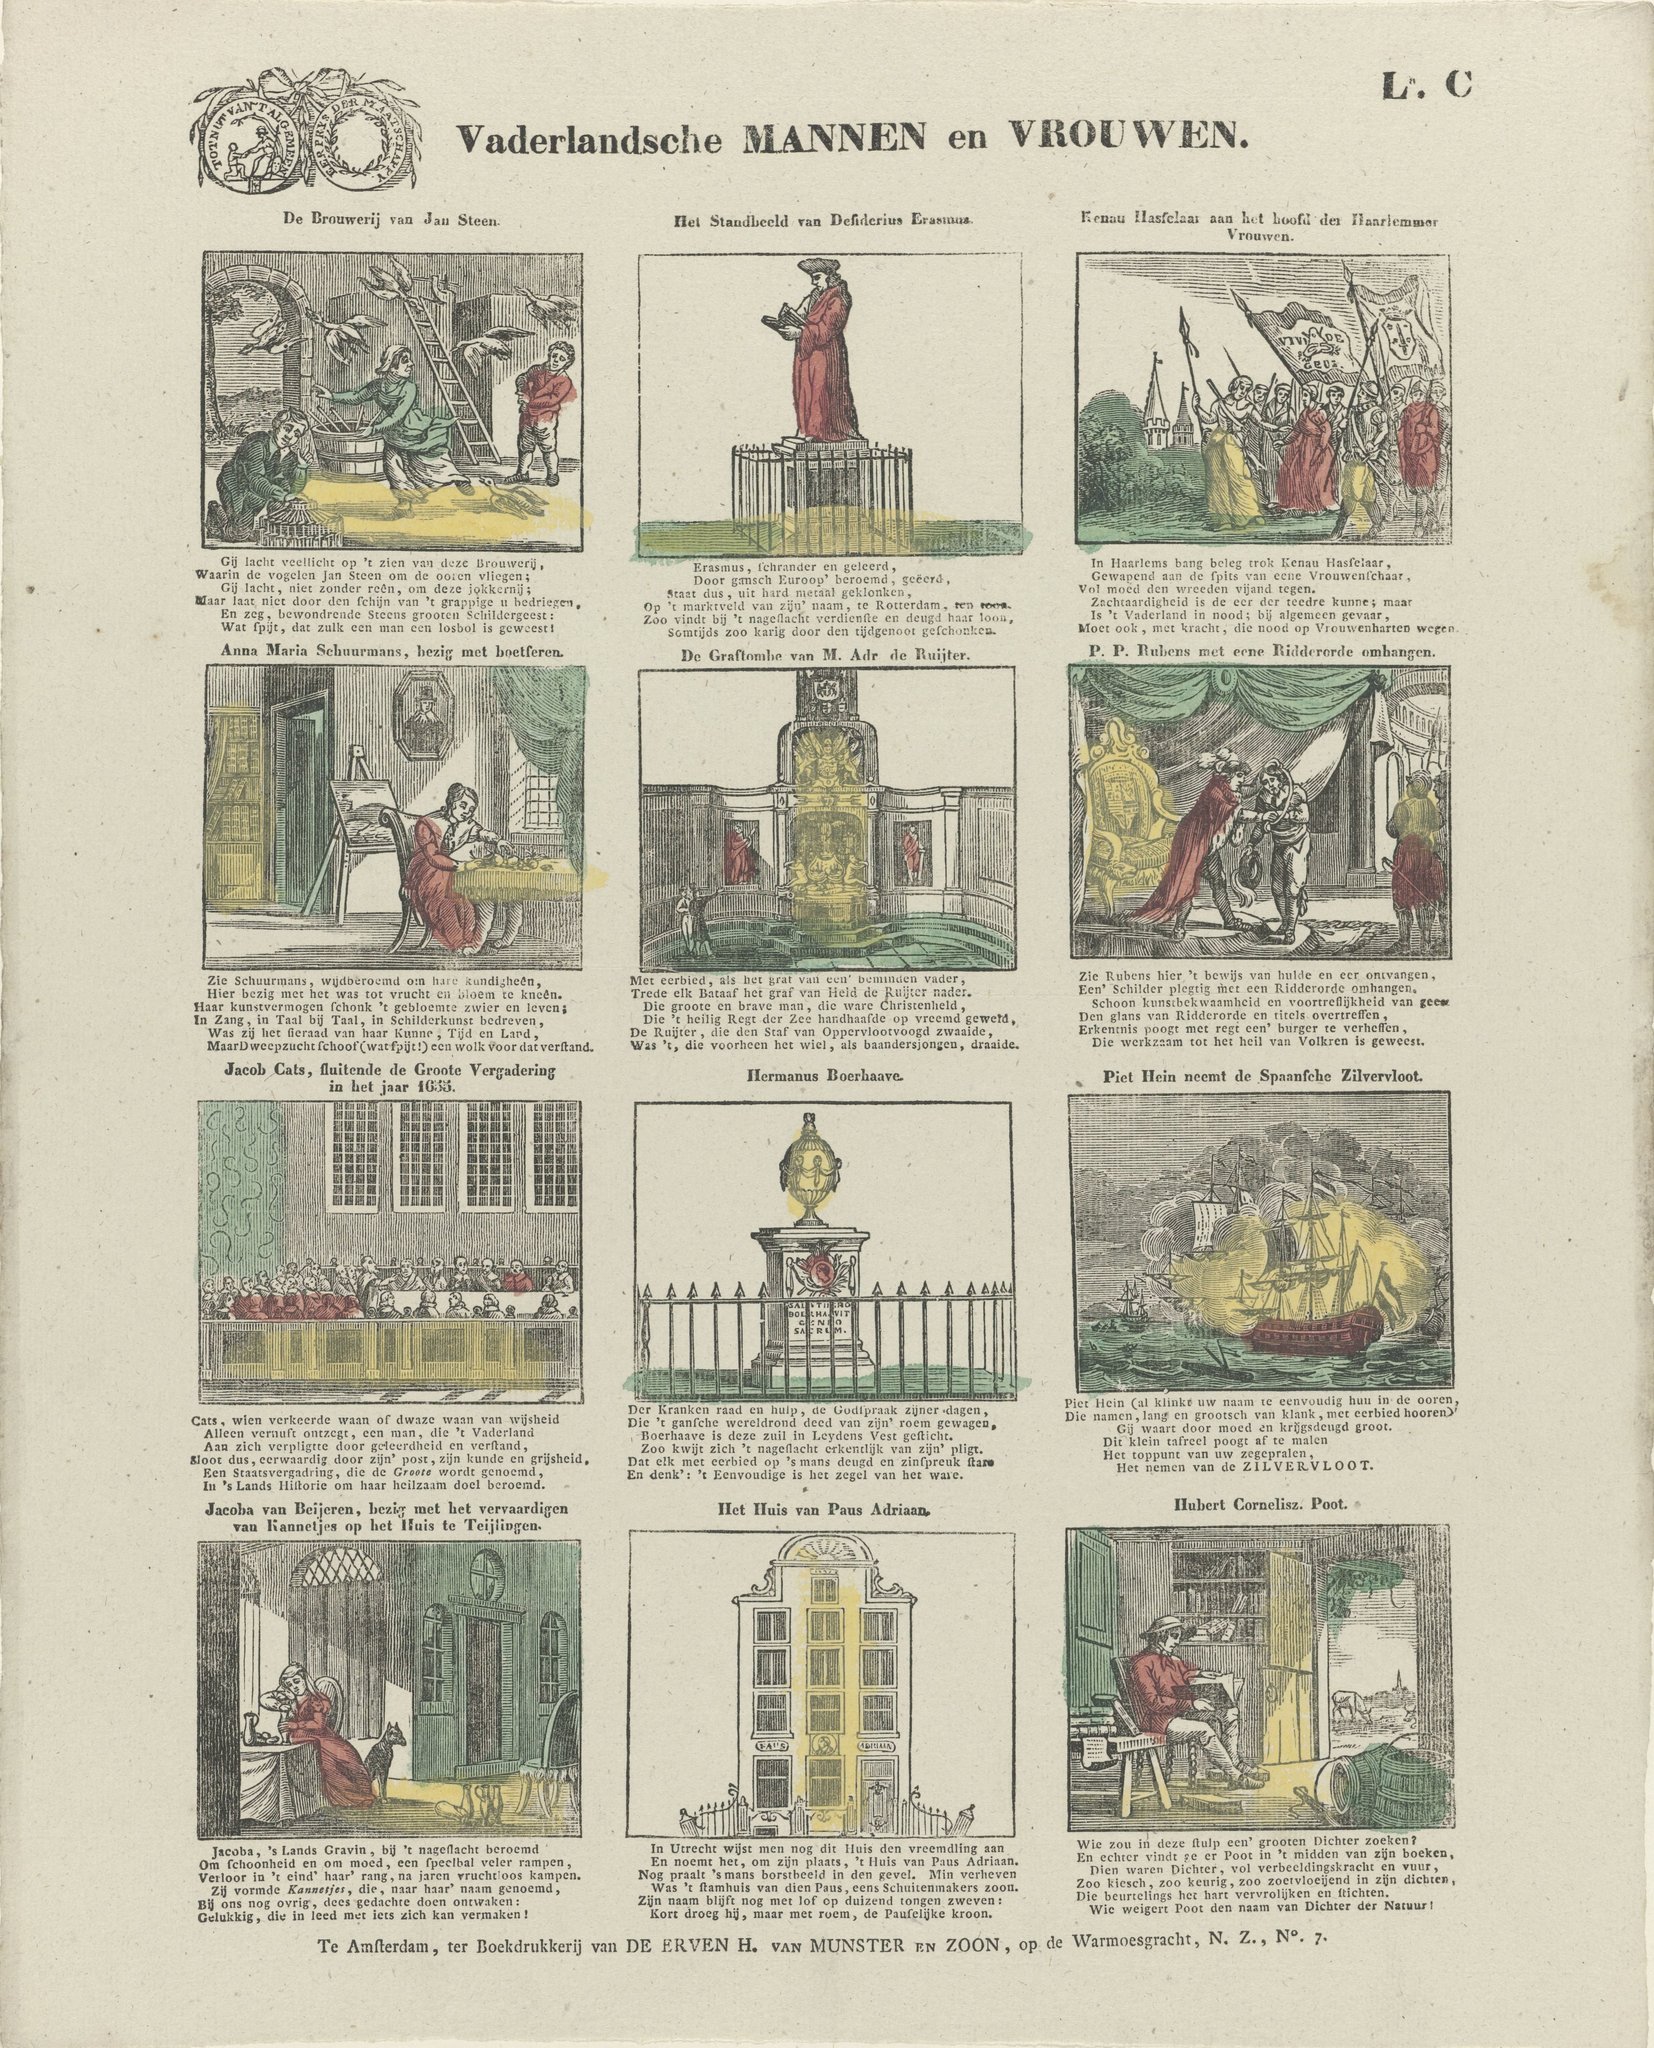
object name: popular print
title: Vaderlandsche mannen en vrouwen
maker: alexander cranendoncq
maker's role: draughtsman, print maker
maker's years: 1799-1869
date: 1829-1856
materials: paper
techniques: colour, letterpress printing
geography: amsterdam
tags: cologne, anna maria van schurman, jan havicksz. steen, jacoba of bavaria (countess of hainaut), rotterdam, desiderius erasmus, flushing, michiel adriaenszoon de ruyter, delfshaven, hubert kornelisz. poot, antwerp, painter, print maker, peter paul rubens, utrecht, clergyman, hermanus boerhaave, housing, monument, statue, classical mythology and ancient history, netherlands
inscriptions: collector's mark: Lugt 2760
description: Blad met 12 voorstellingen van bezigheden, huizen of monumenten van beroemde Nederlandse mannen en vrouwen, waaronder Jan Steen, Erasmus en Jacob Cats. Onder elke afbeelding een zesregelig vers en boven elke afbeelding een titel. Linksboven het zegel van de Maatschappij tot Nut van 't Algemeen. Gemerkt rechtsboven: L. C.